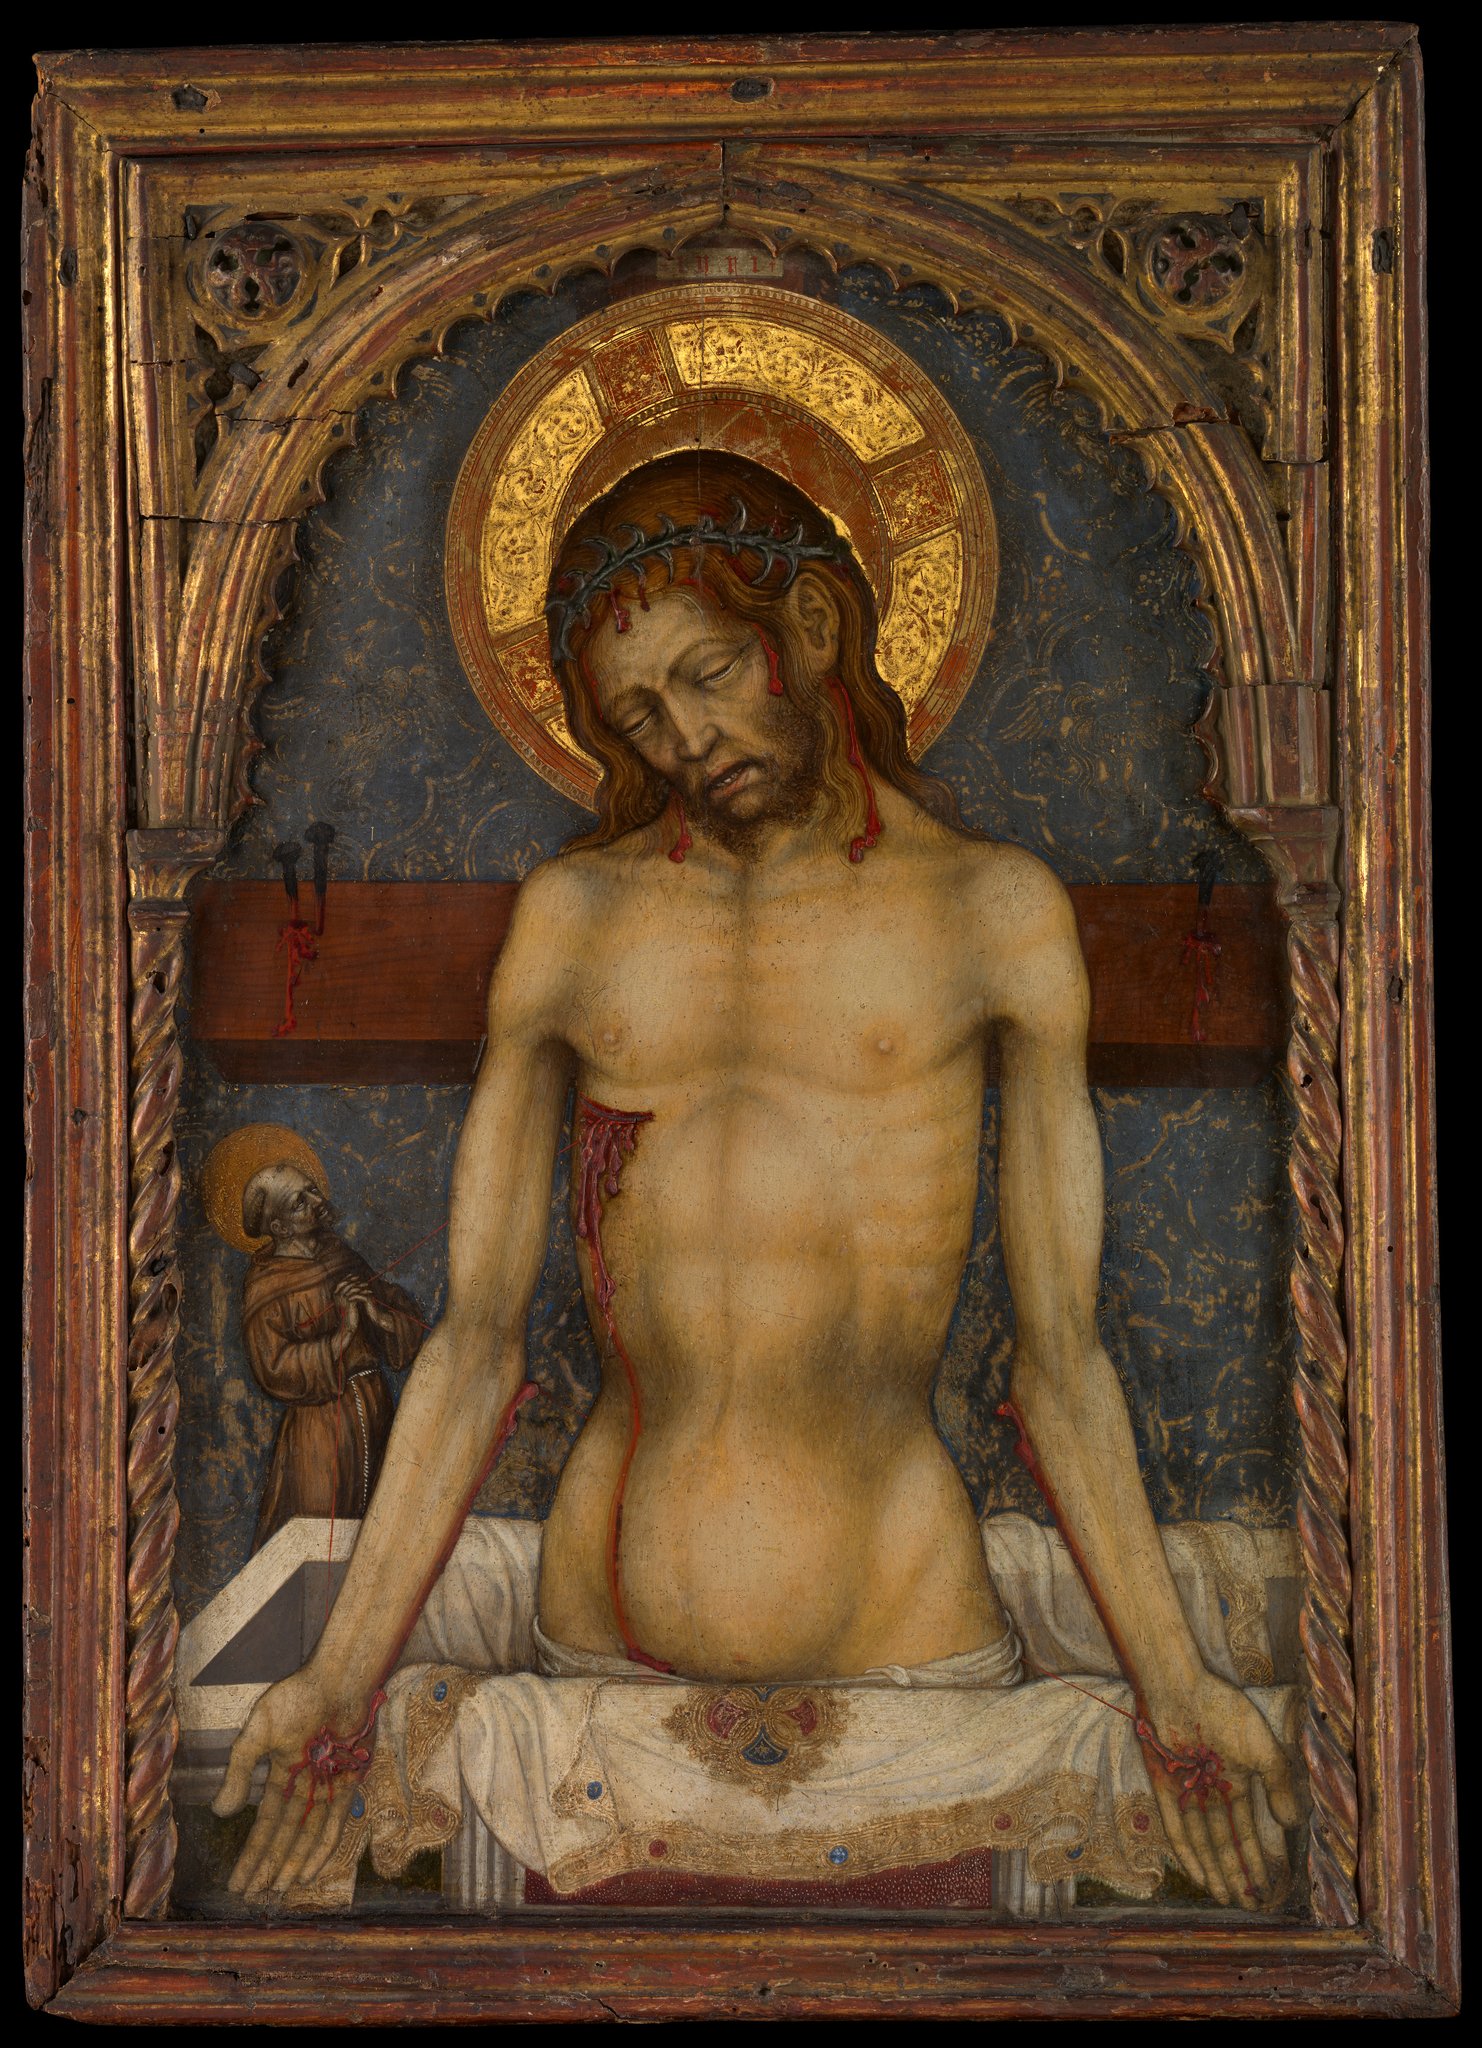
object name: painting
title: The Man of Sorrows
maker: michele giambono (michele giovanni bono)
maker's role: artist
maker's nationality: italian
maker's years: 1420-1462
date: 1430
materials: gold, paint, wood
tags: sadness,saint francis,jesus